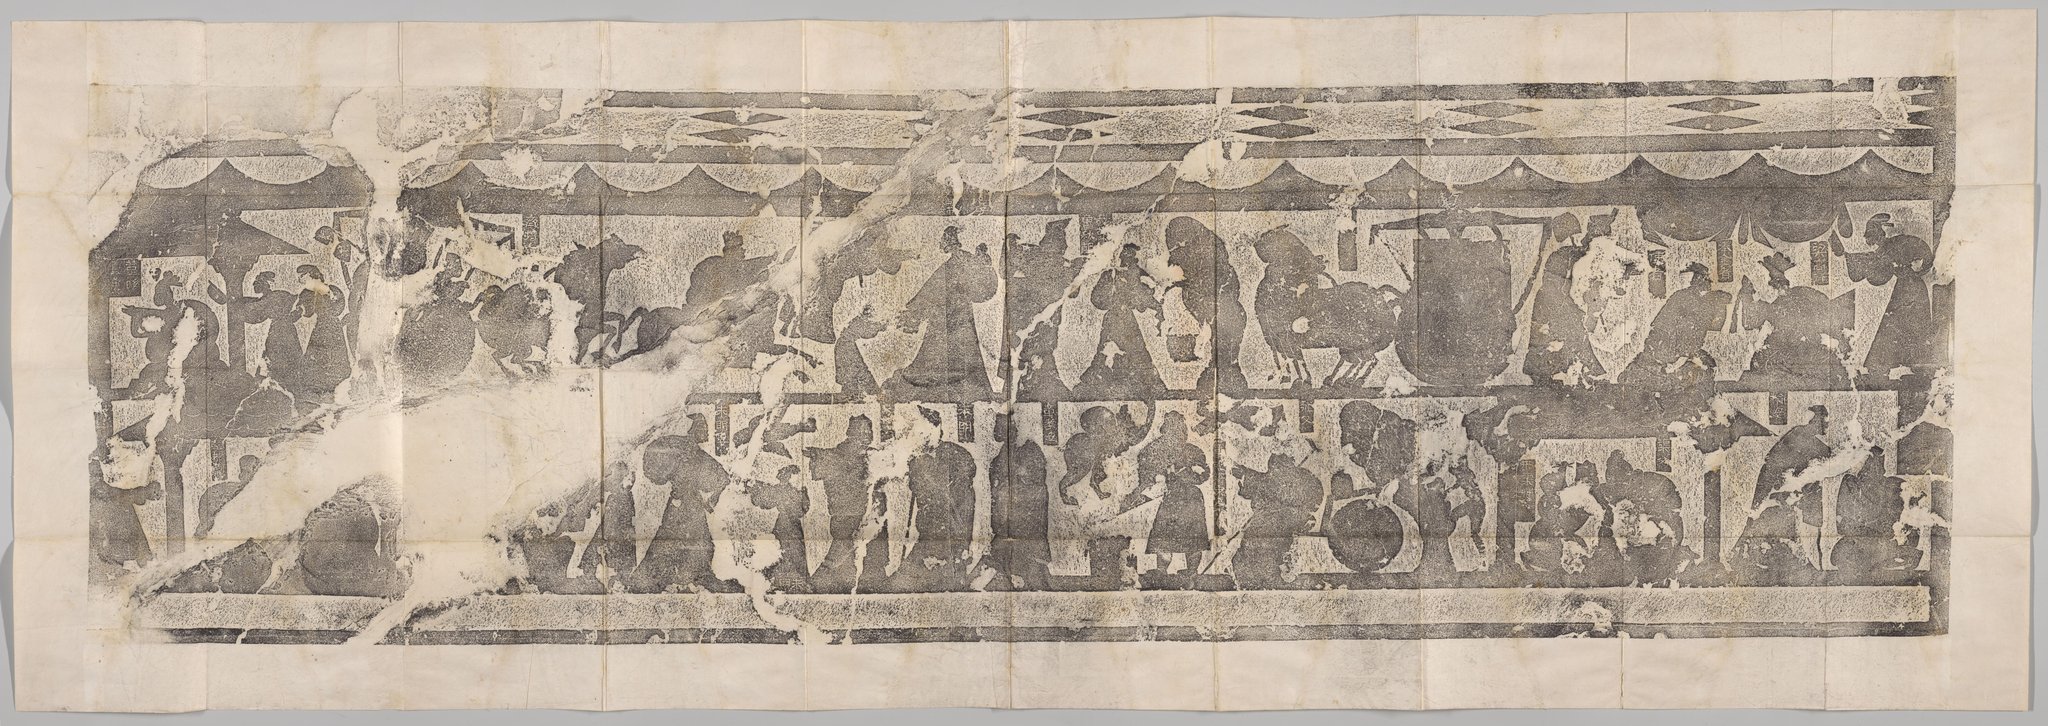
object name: wrijfprent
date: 1900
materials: ink, paper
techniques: rubbing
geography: china